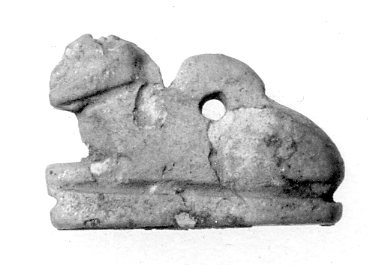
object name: amulet, recumbent ram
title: Ram amulet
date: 664-332 BCE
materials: faience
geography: egypt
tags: rams